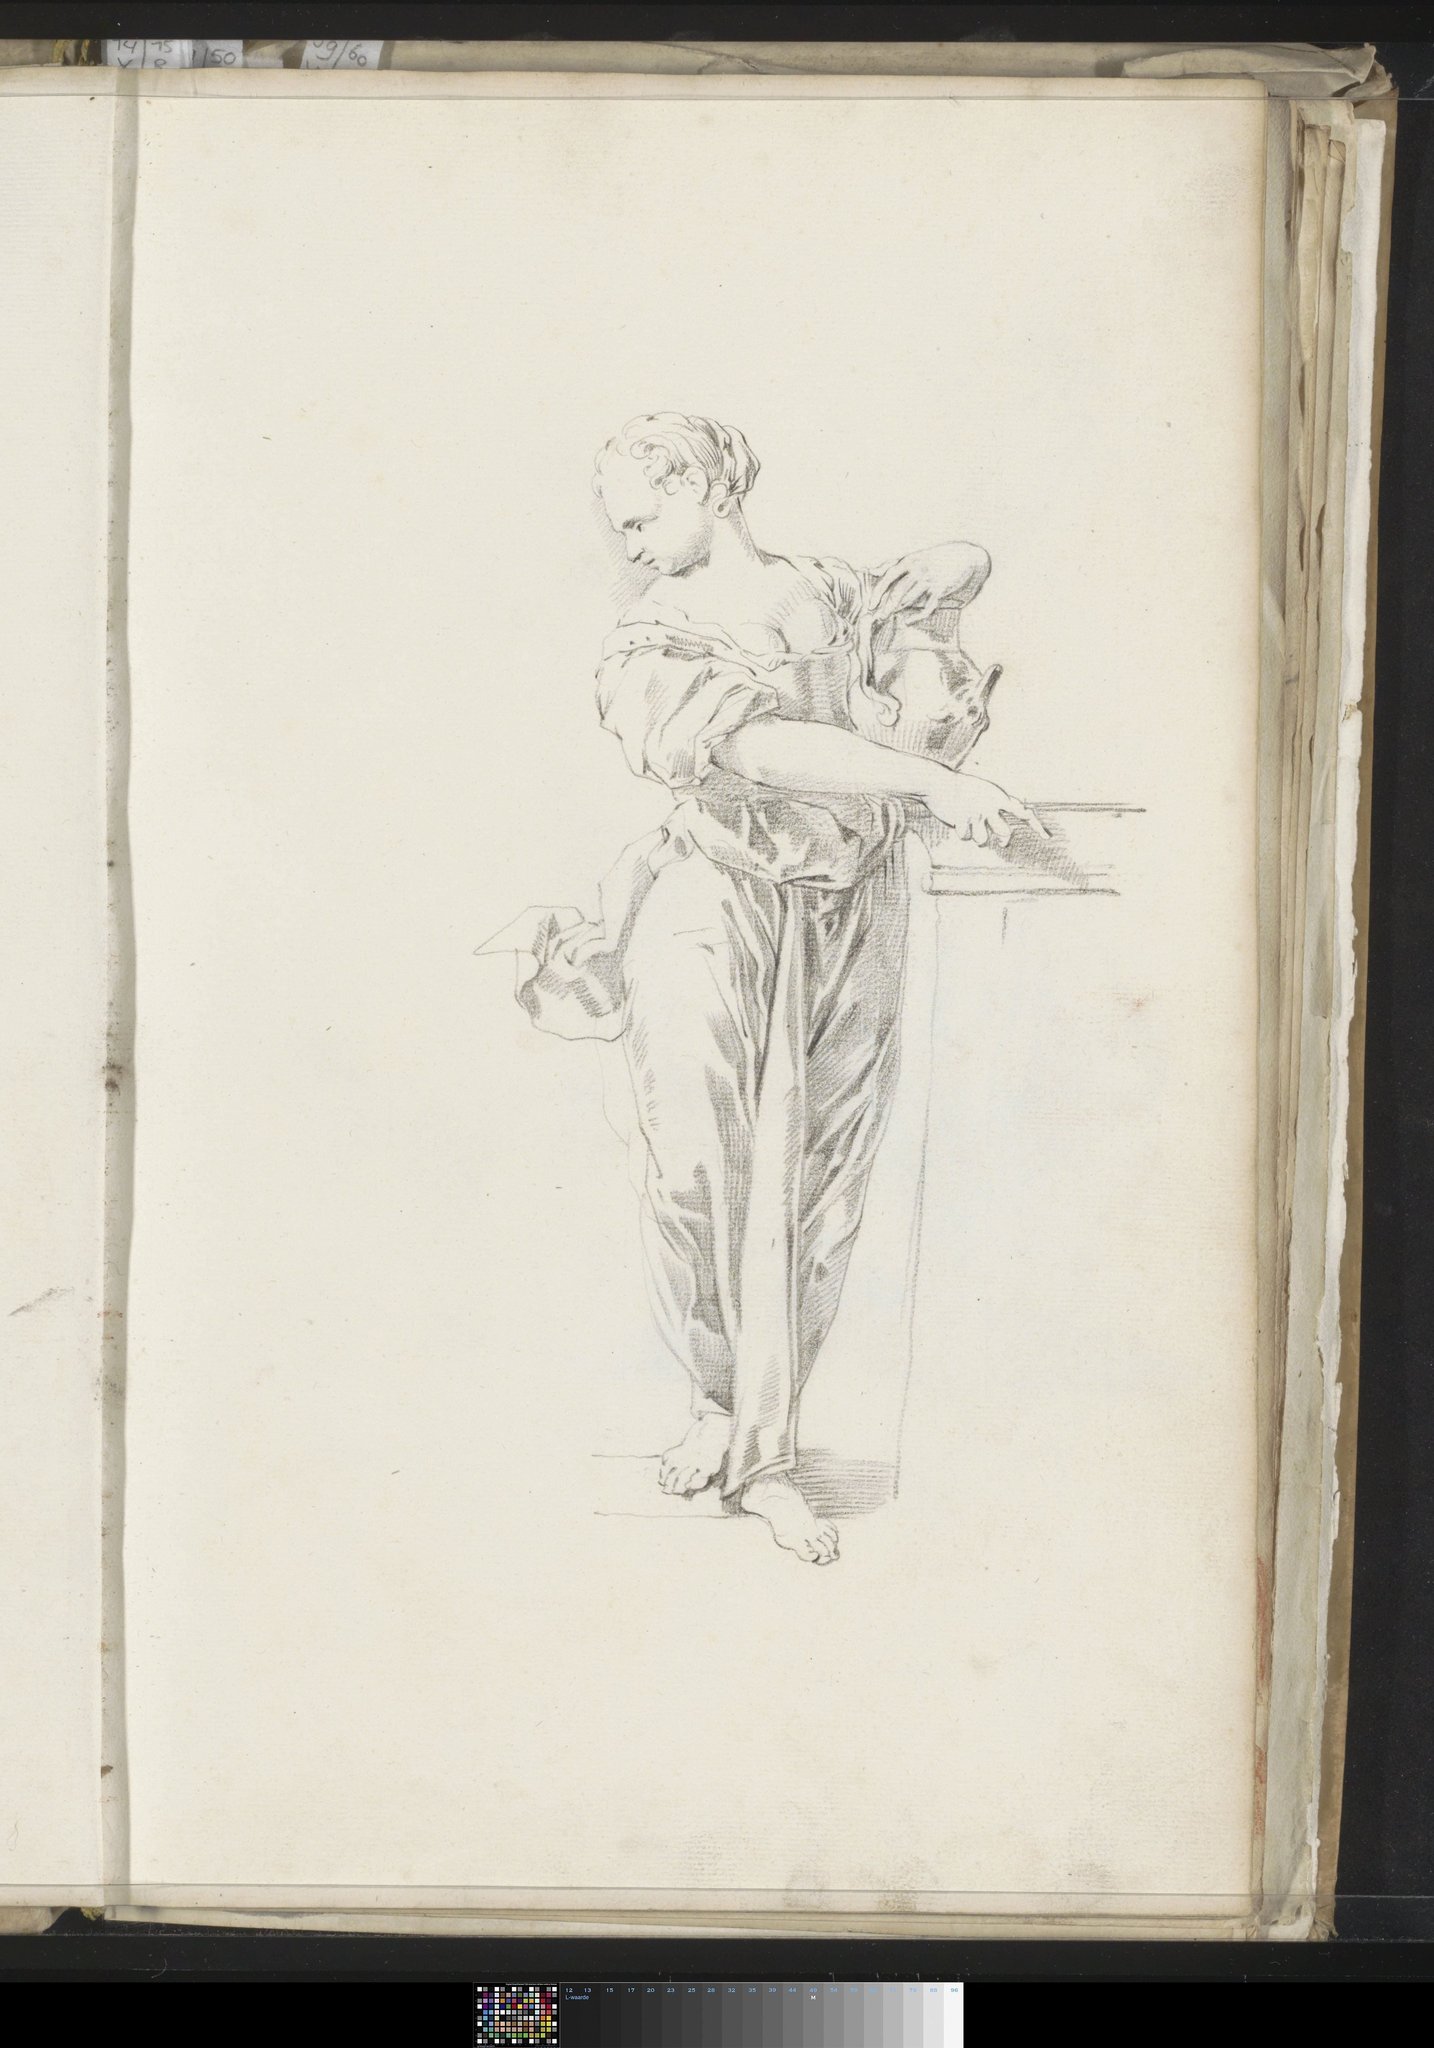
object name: sketchbook leaf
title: Staande vrouw met kruik, mogelijk Hebe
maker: jacob toorenvliet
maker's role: draughtsman, painter, print maker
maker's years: 1640-1719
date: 1701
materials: chalk, paper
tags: standing figure, standing figure - aa - female human figure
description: Blad 14 recto uit een schetsboek met 63 bladen.